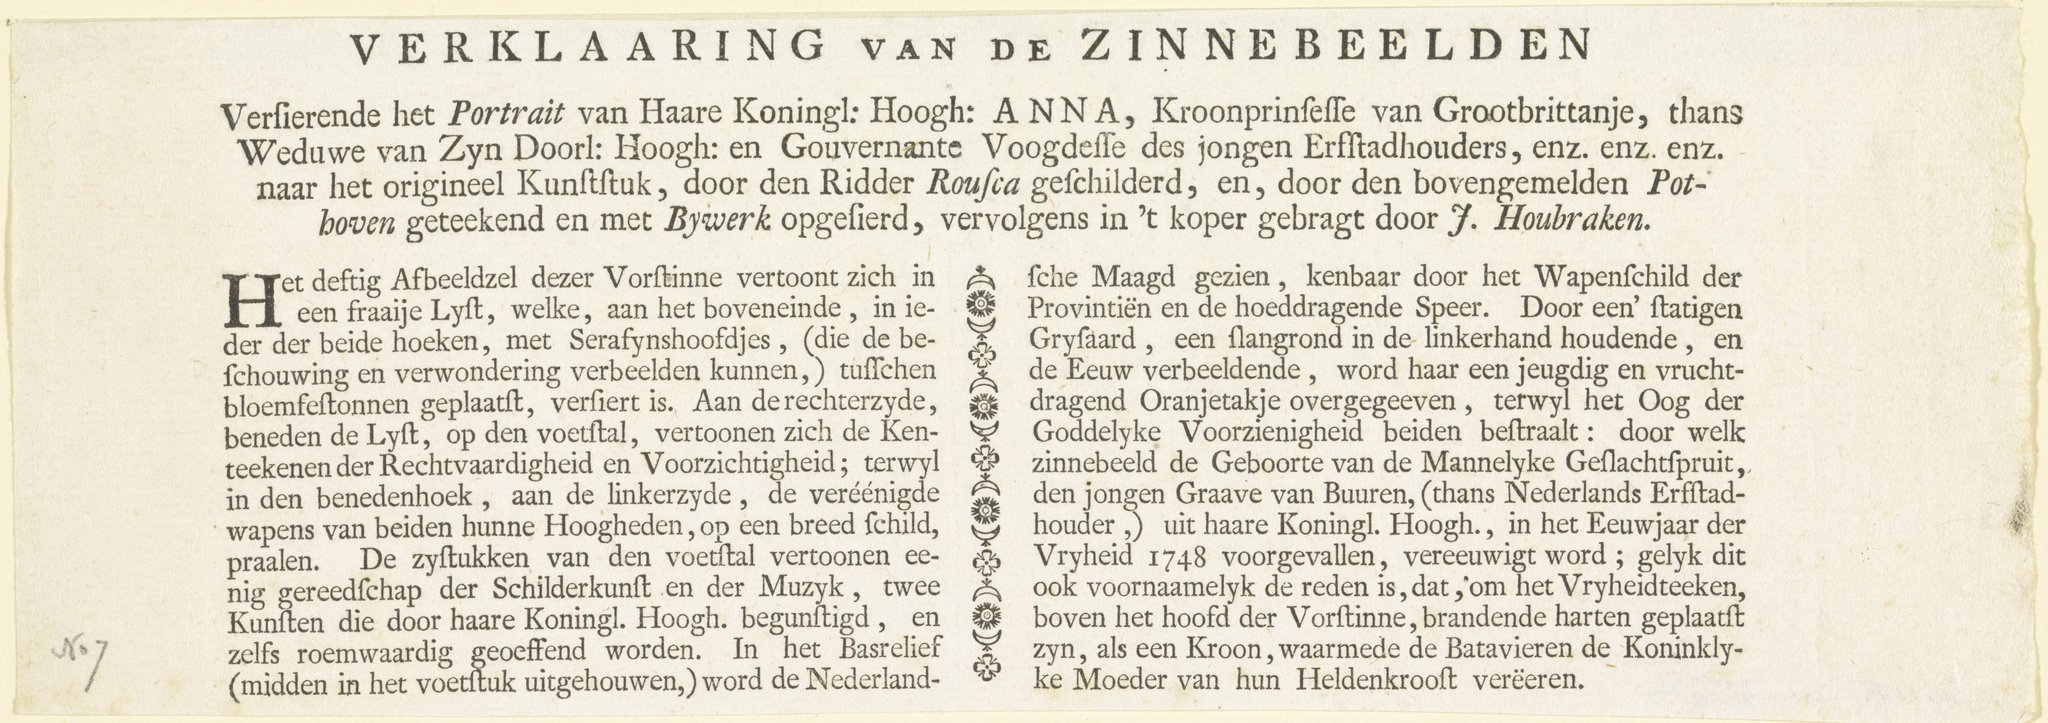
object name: text sheet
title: Tekst bij het portret van Anna van Hannover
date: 1751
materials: paper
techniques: letterpress printing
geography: amsterdam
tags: anna van hannover